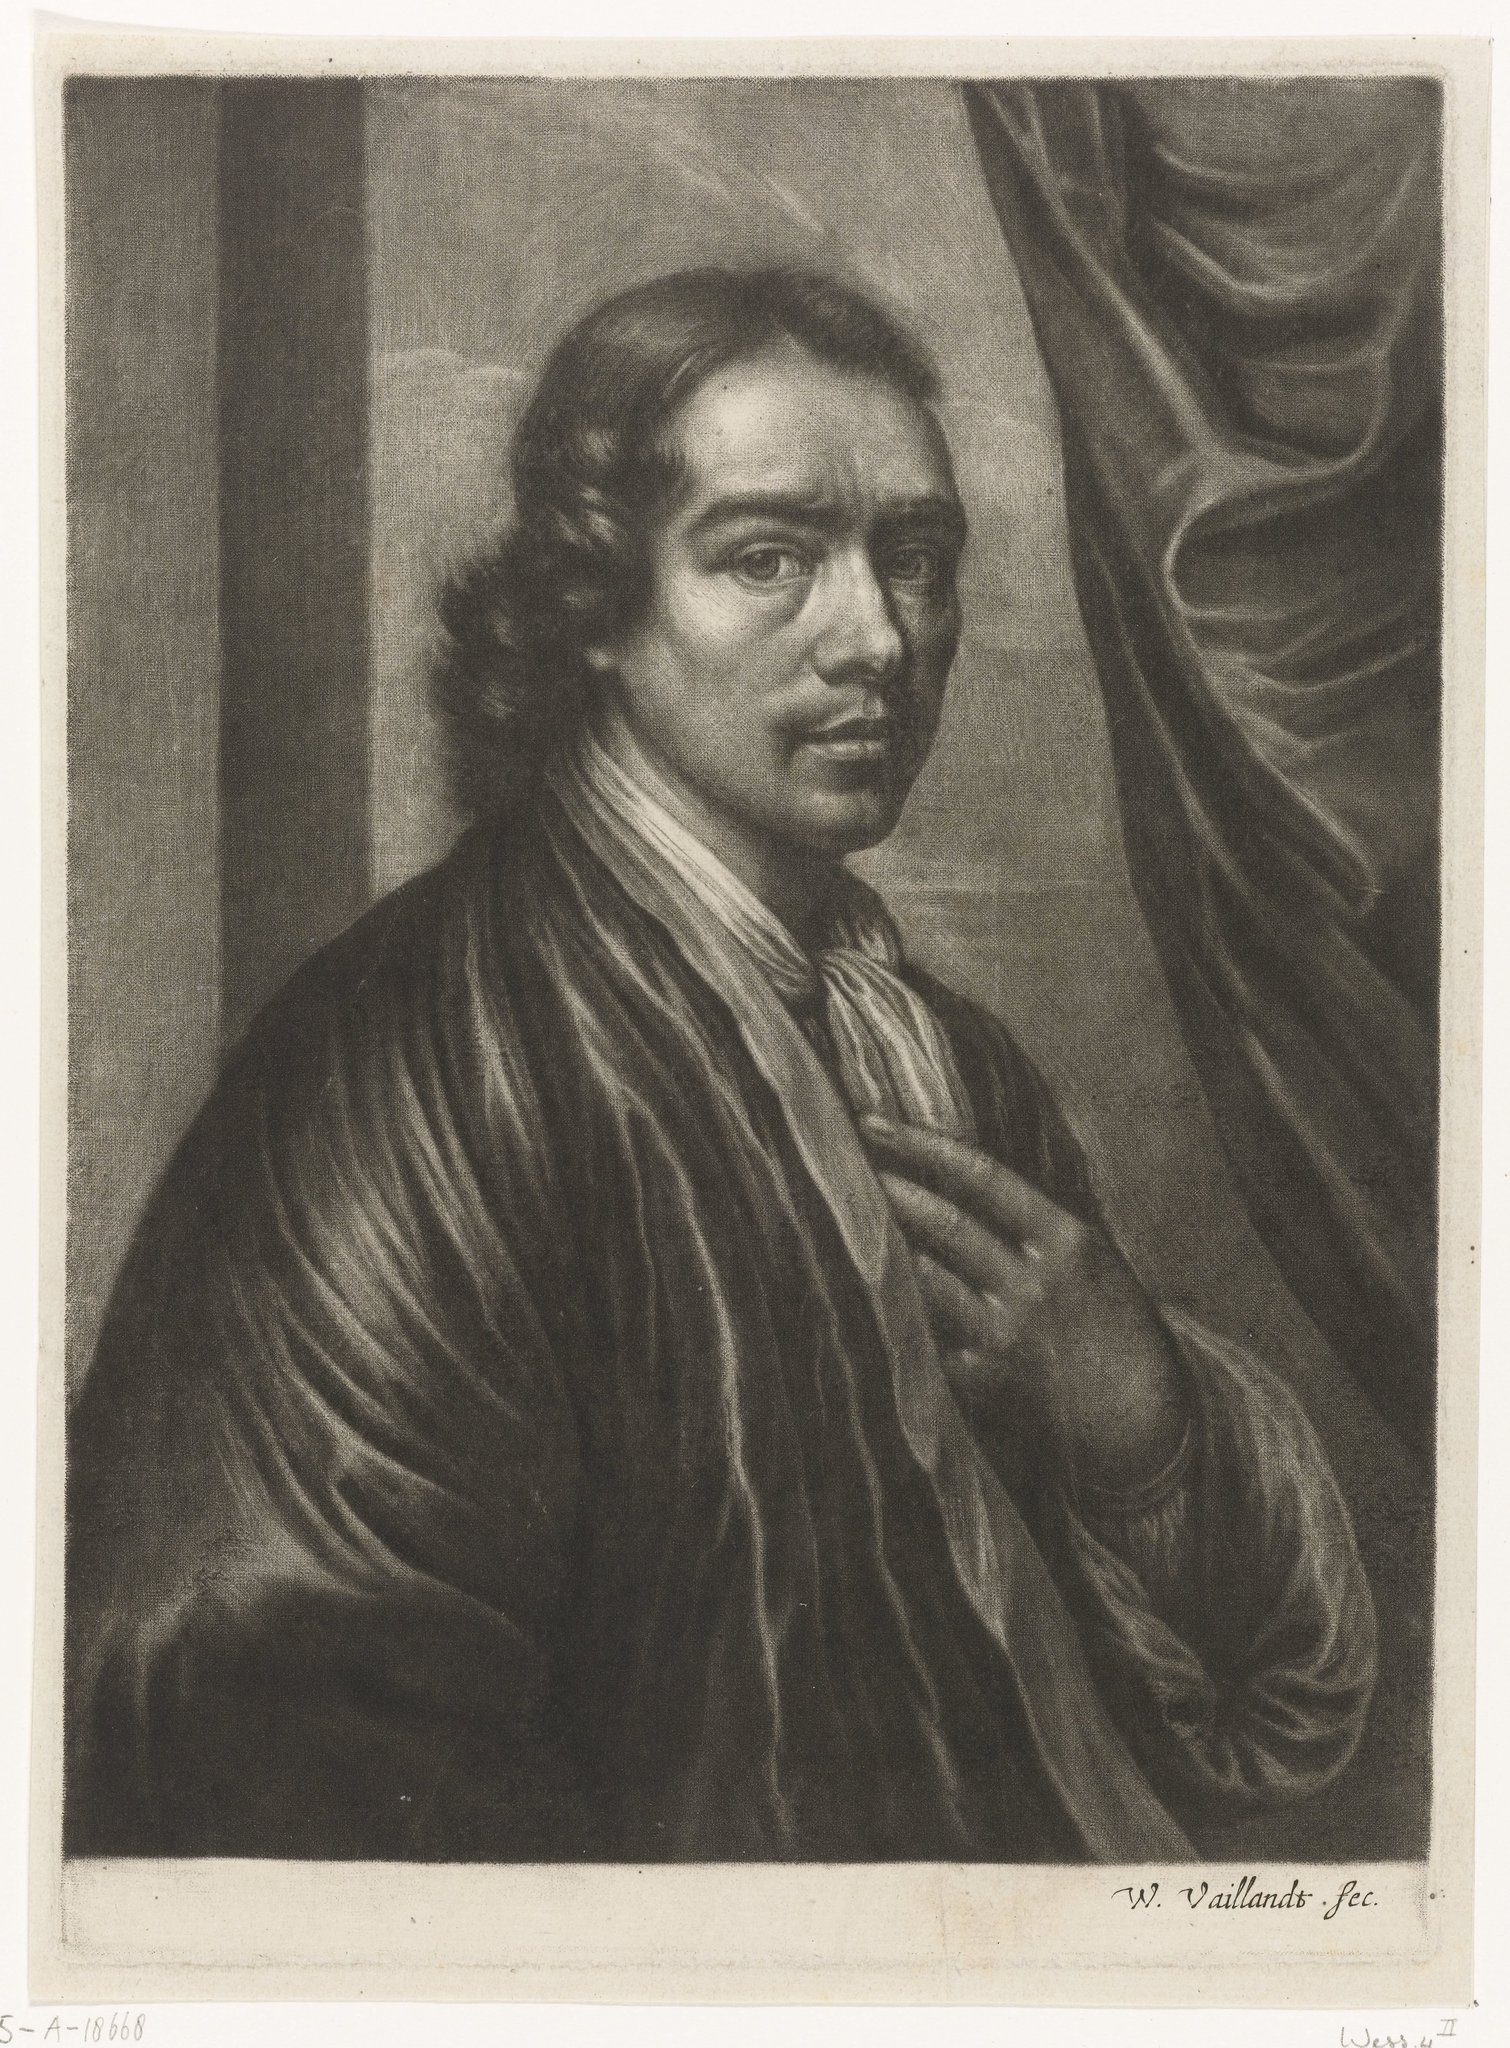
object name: print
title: Zelfportret van Wallerant Vaillant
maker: wallerant vaillant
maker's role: draughtsman, painter, print maker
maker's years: 1623-1677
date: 1671-1677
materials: paper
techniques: mezzotint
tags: lille, amsterdam, draughtsman, wallerant vaillant, portrait, self-portrait of painter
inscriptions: collector's mark: Lugt 2228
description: De schilder, tekenaar en prentmaker Wallerant Vaillant staat voor een venster met een gordijn. Op de achtergrond een wolkenlucht.